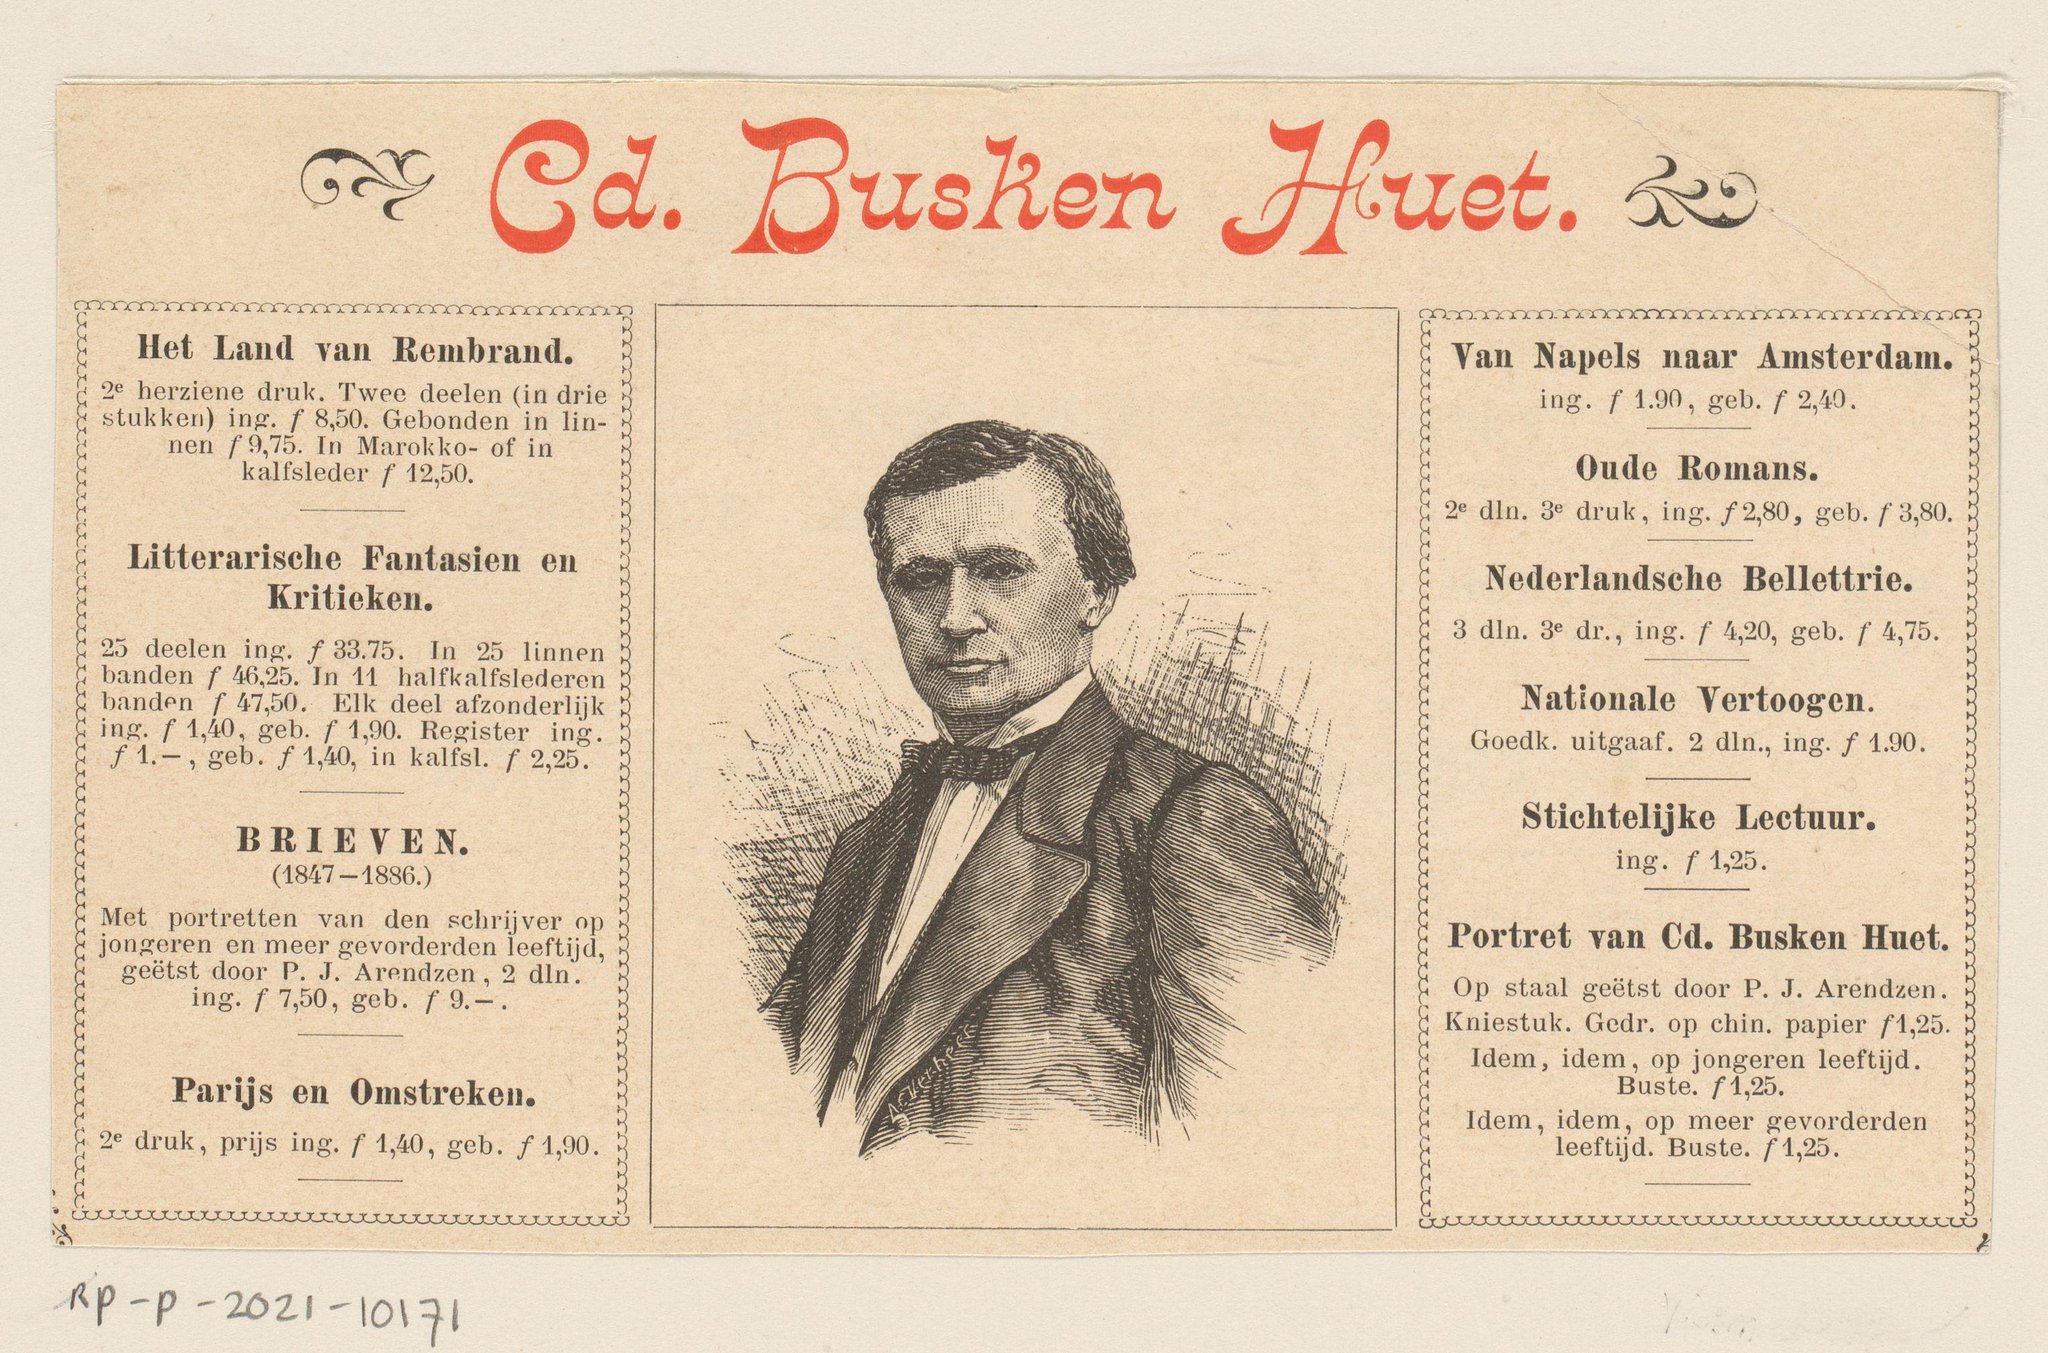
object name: print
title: Portret van Conrad Busken Huet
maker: arnoldus cornelius verhees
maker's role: print maker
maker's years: 1859-1929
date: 1886-1899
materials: paper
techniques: letterpress printing, engraving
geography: netherlands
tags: historical persons, portrait of a writer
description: Met rondom het portret de titels van een aantal van zijn werken en portretten, met prijs.